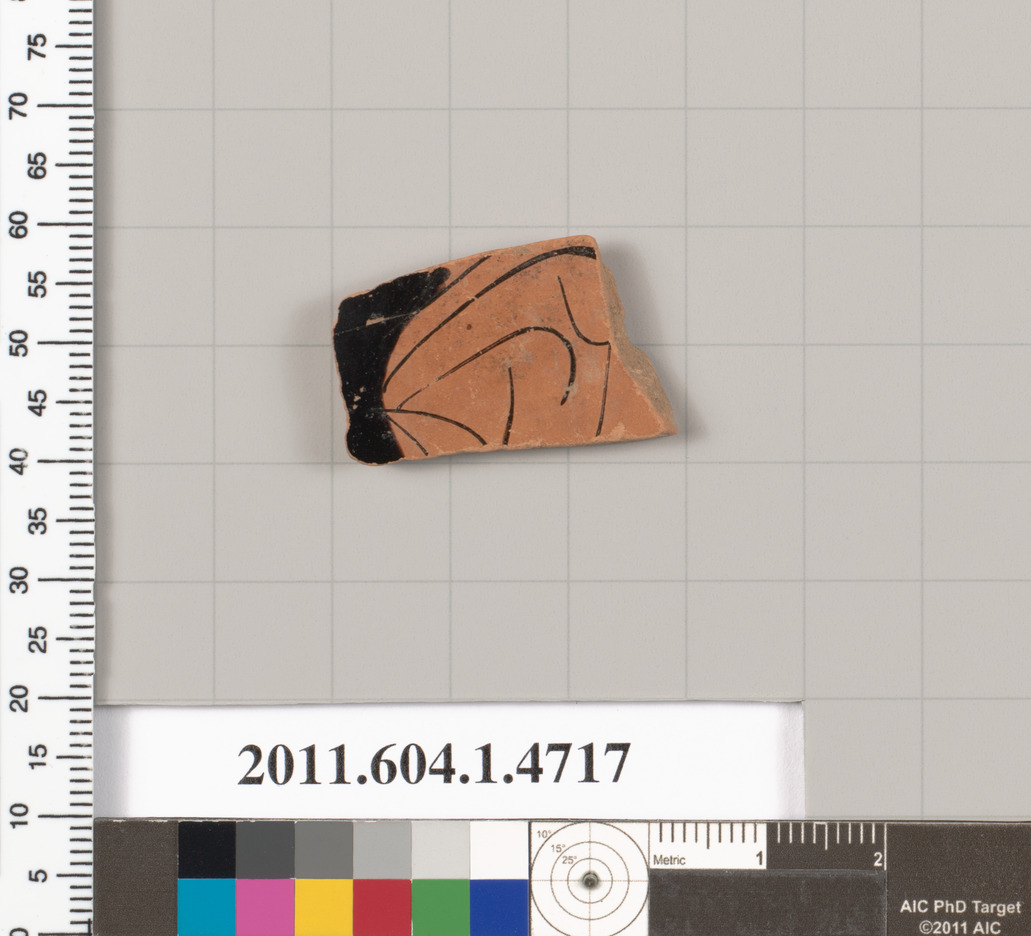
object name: kylix fragment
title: Terracotta fragment of a kylix (drinking cup)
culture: greek, attic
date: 475-451 BCE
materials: terracotta